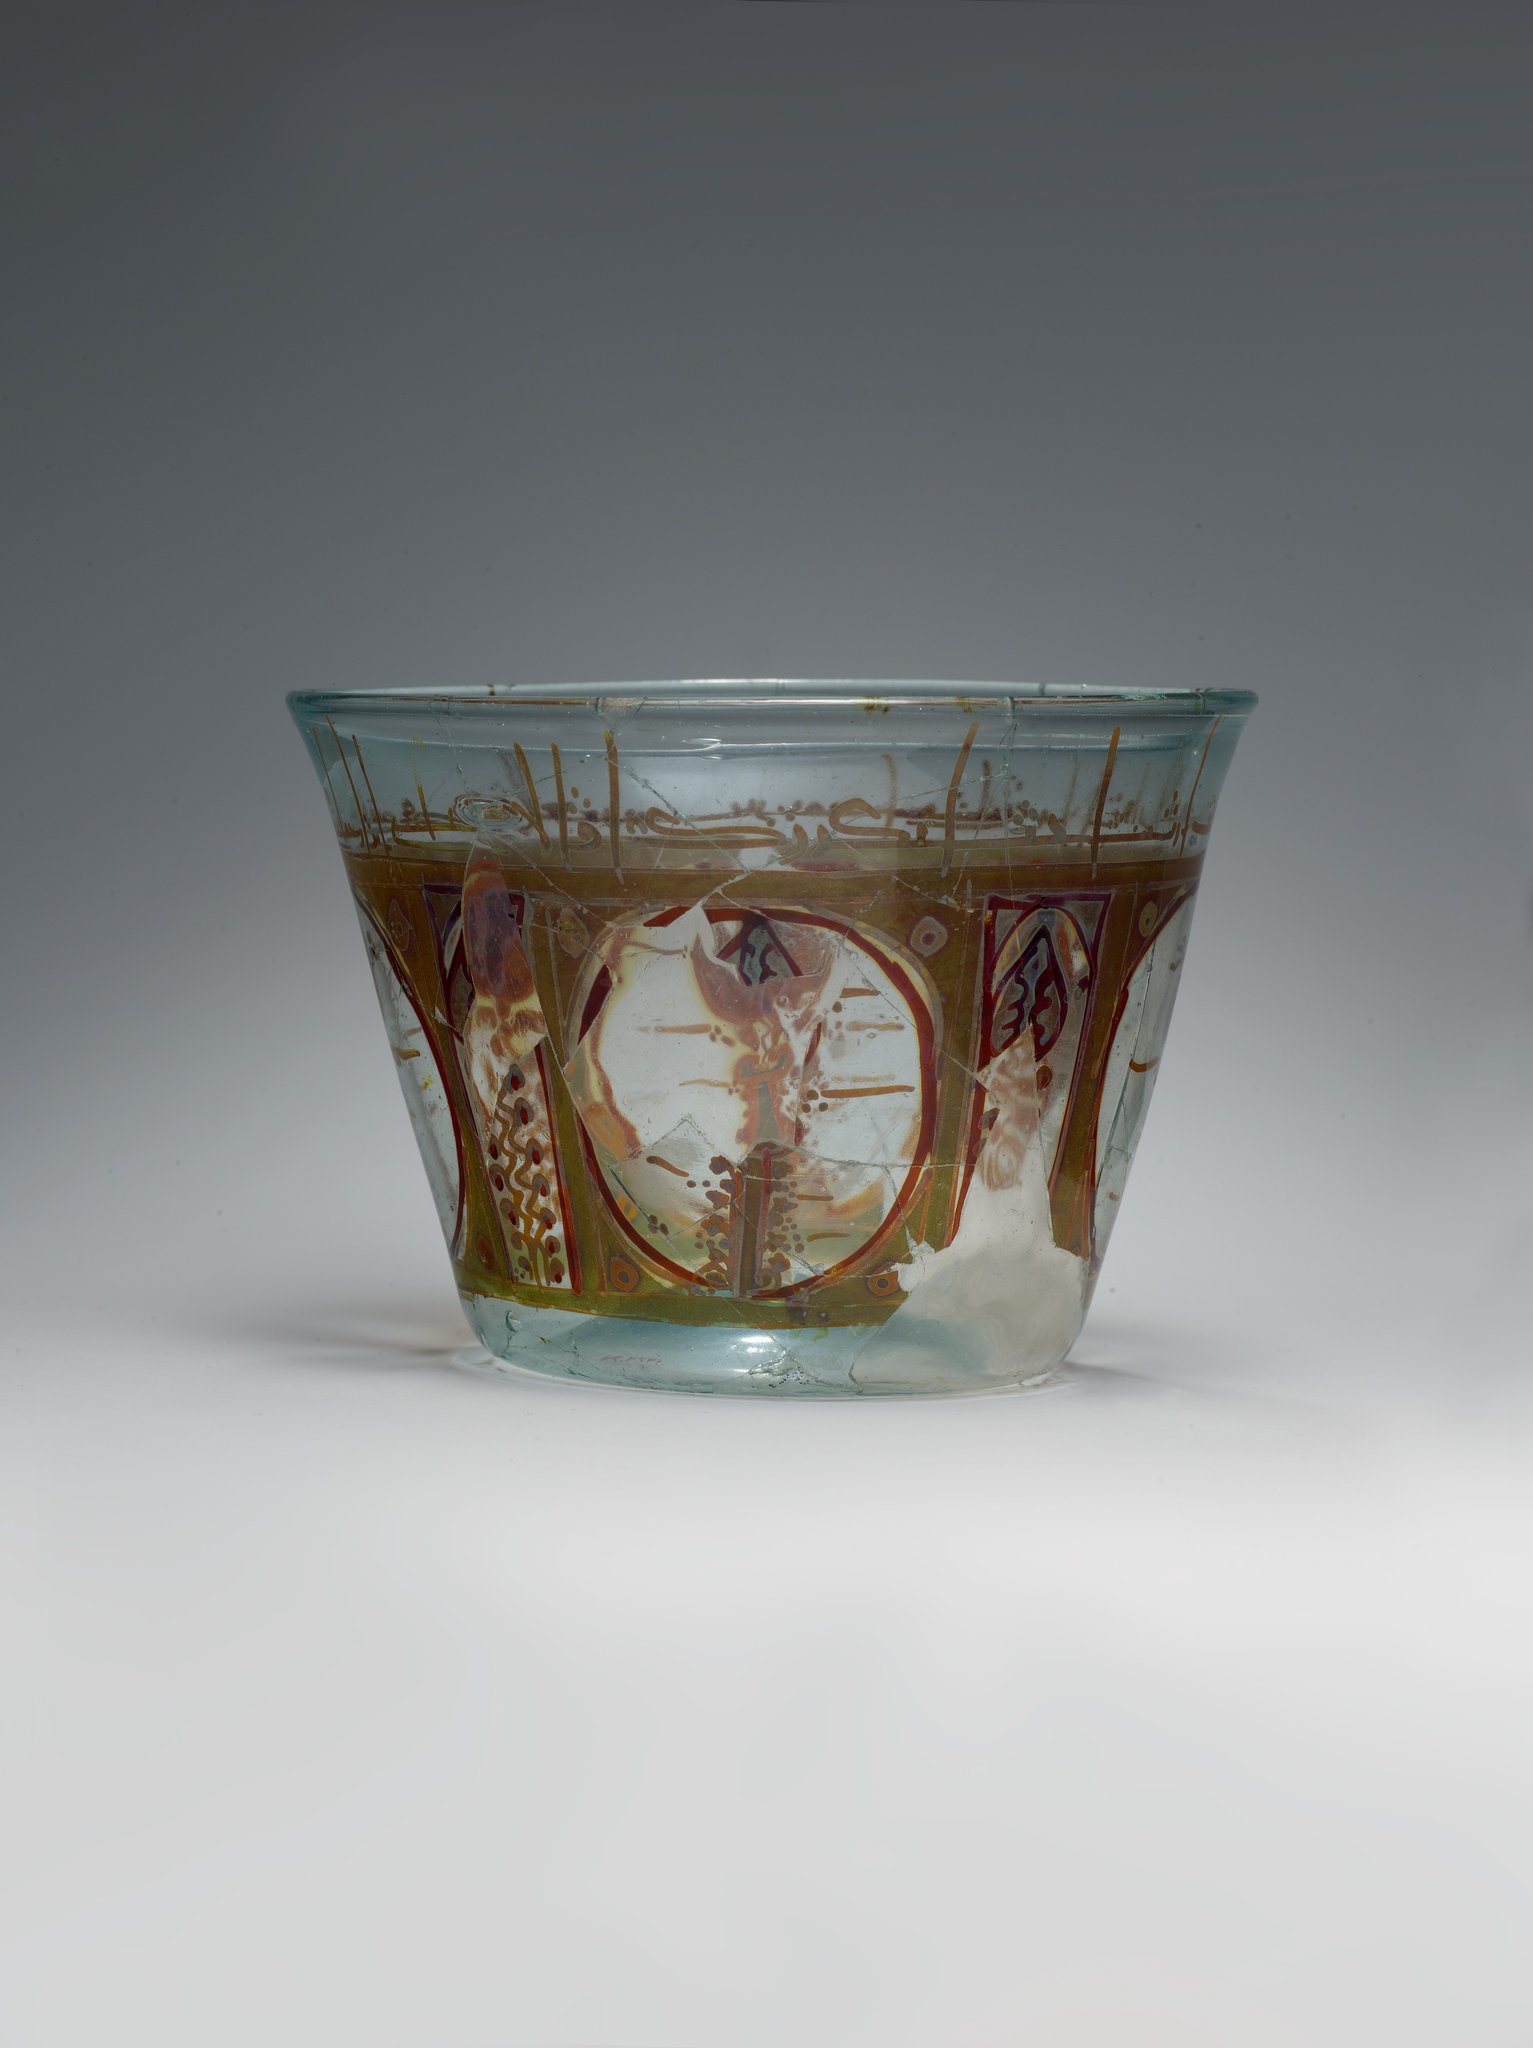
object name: bowl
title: Glass Bowl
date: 967-1033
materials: glass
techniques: glassblowing, stain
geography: egypt